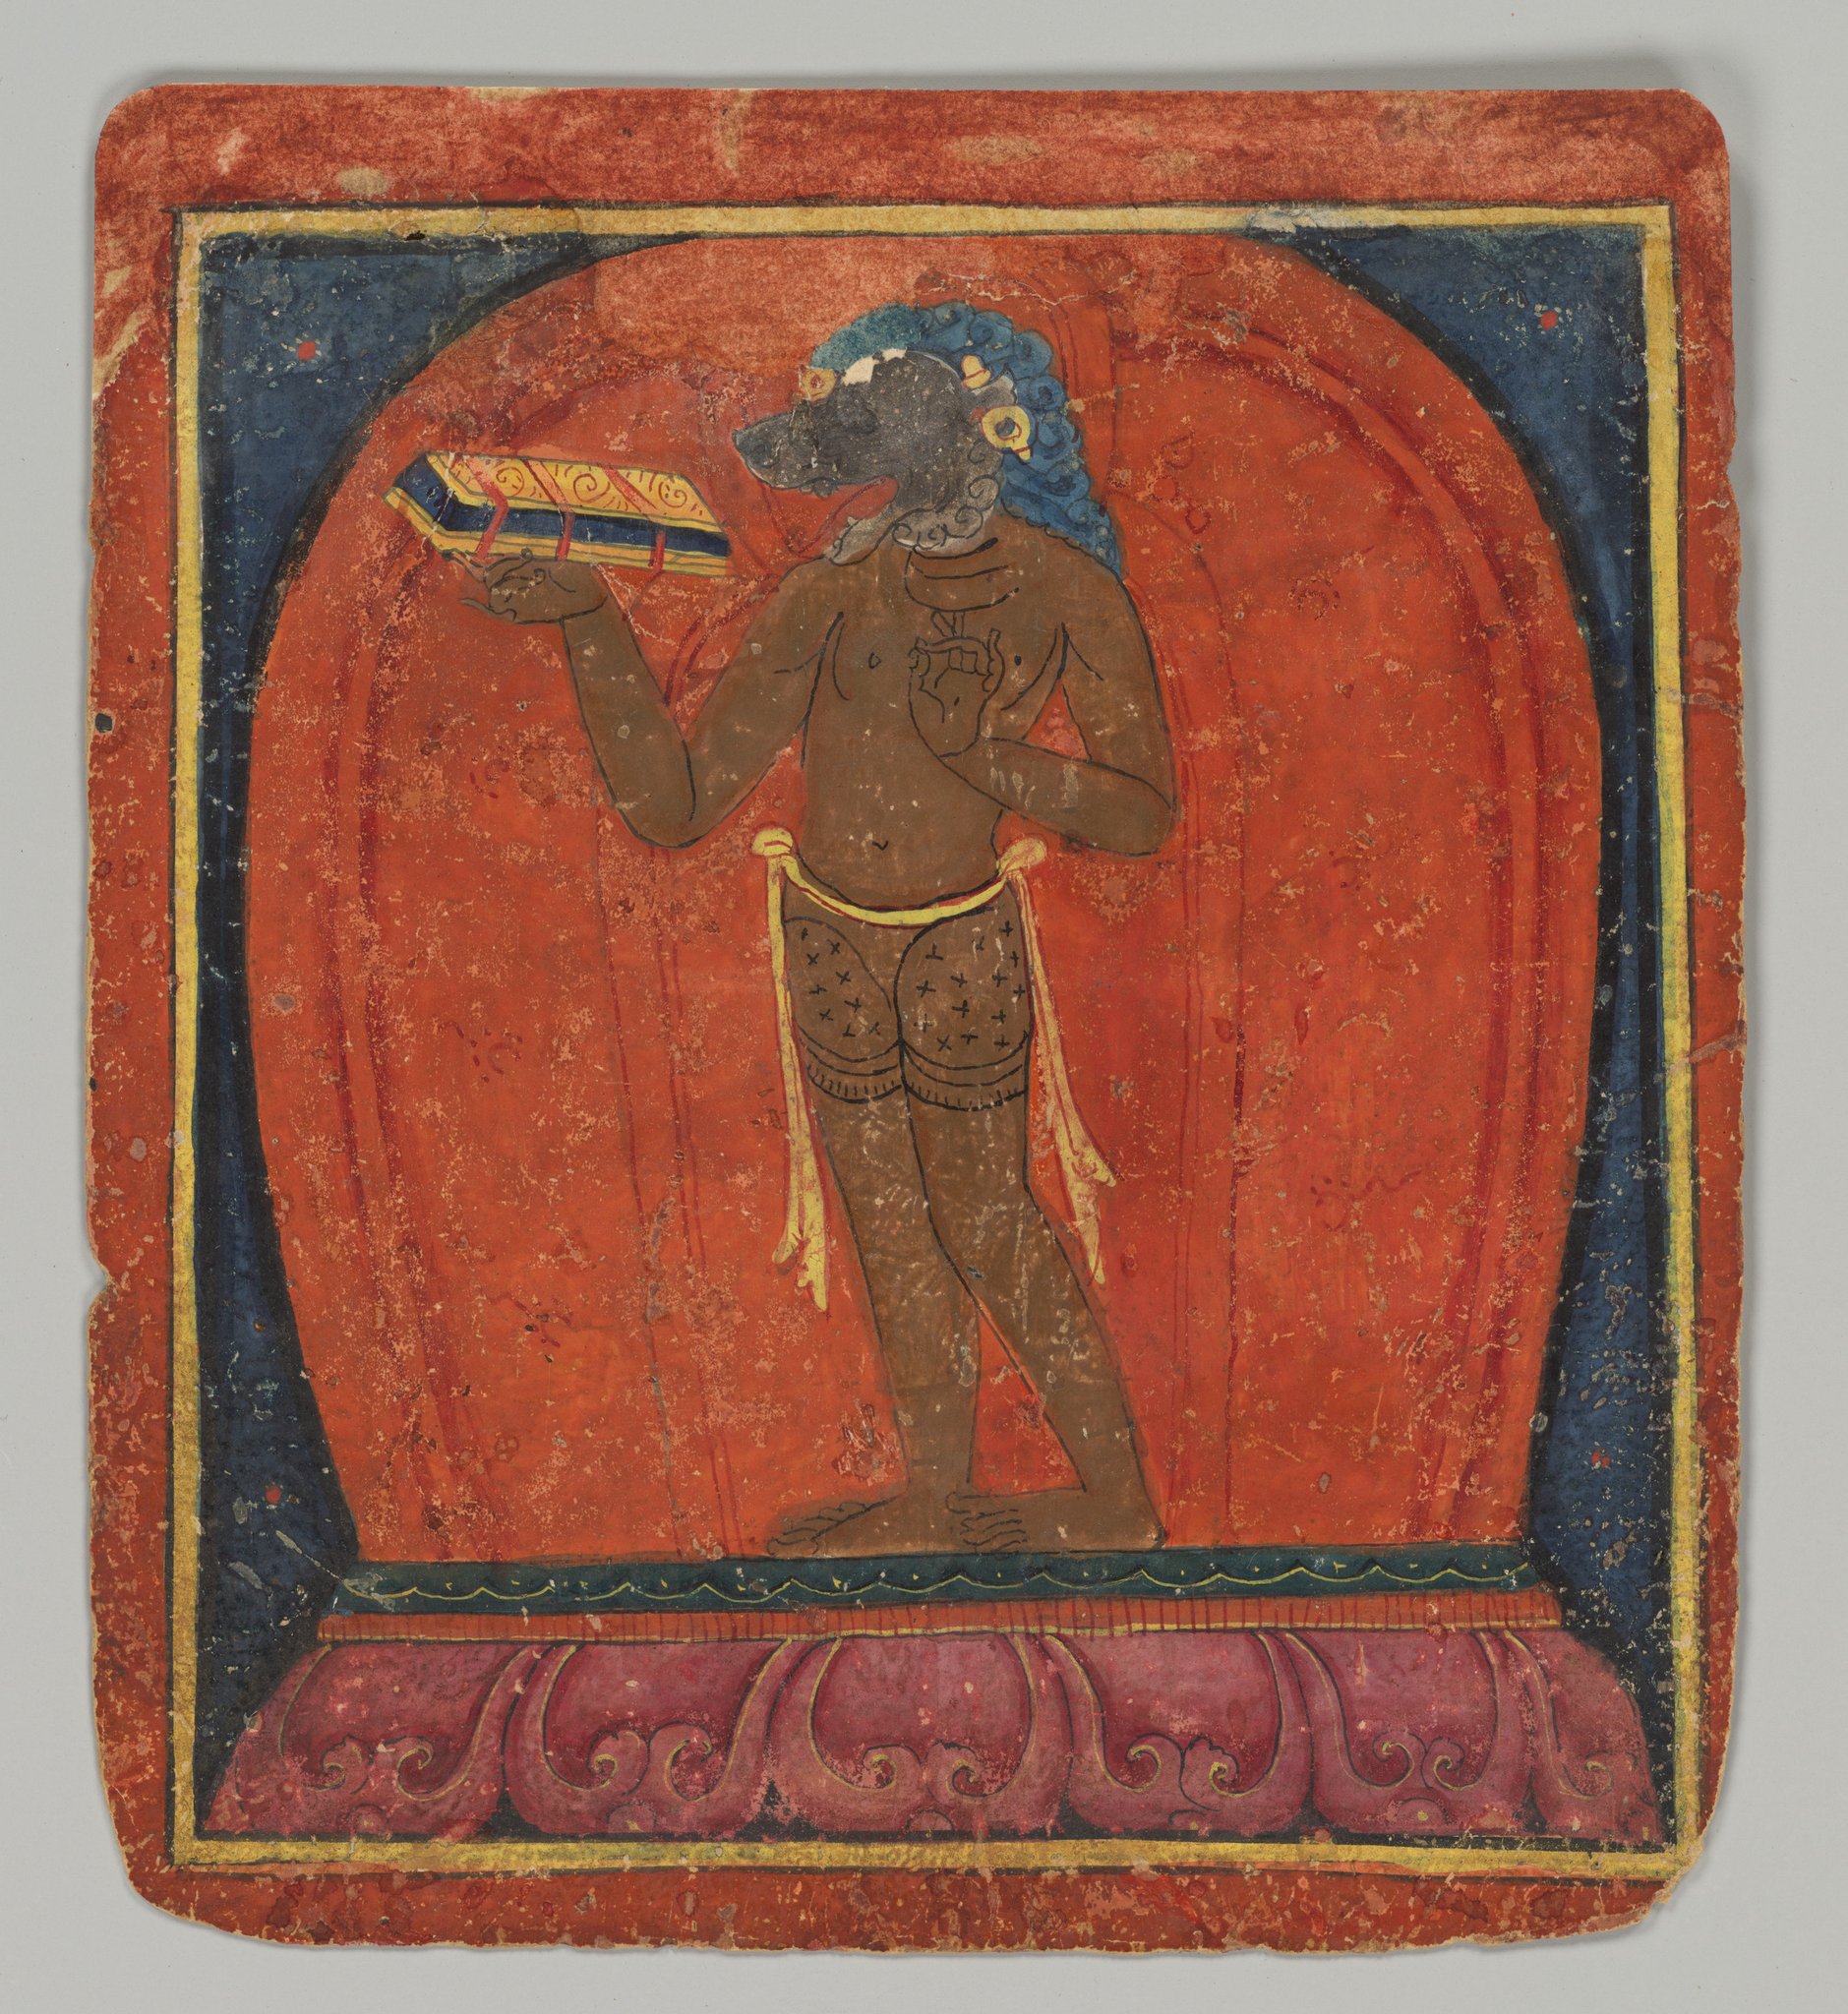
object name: initiation card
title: Initiation Card (Tsakalis)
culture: tibetan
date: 1401-1433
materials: paper, watercolor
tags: deities